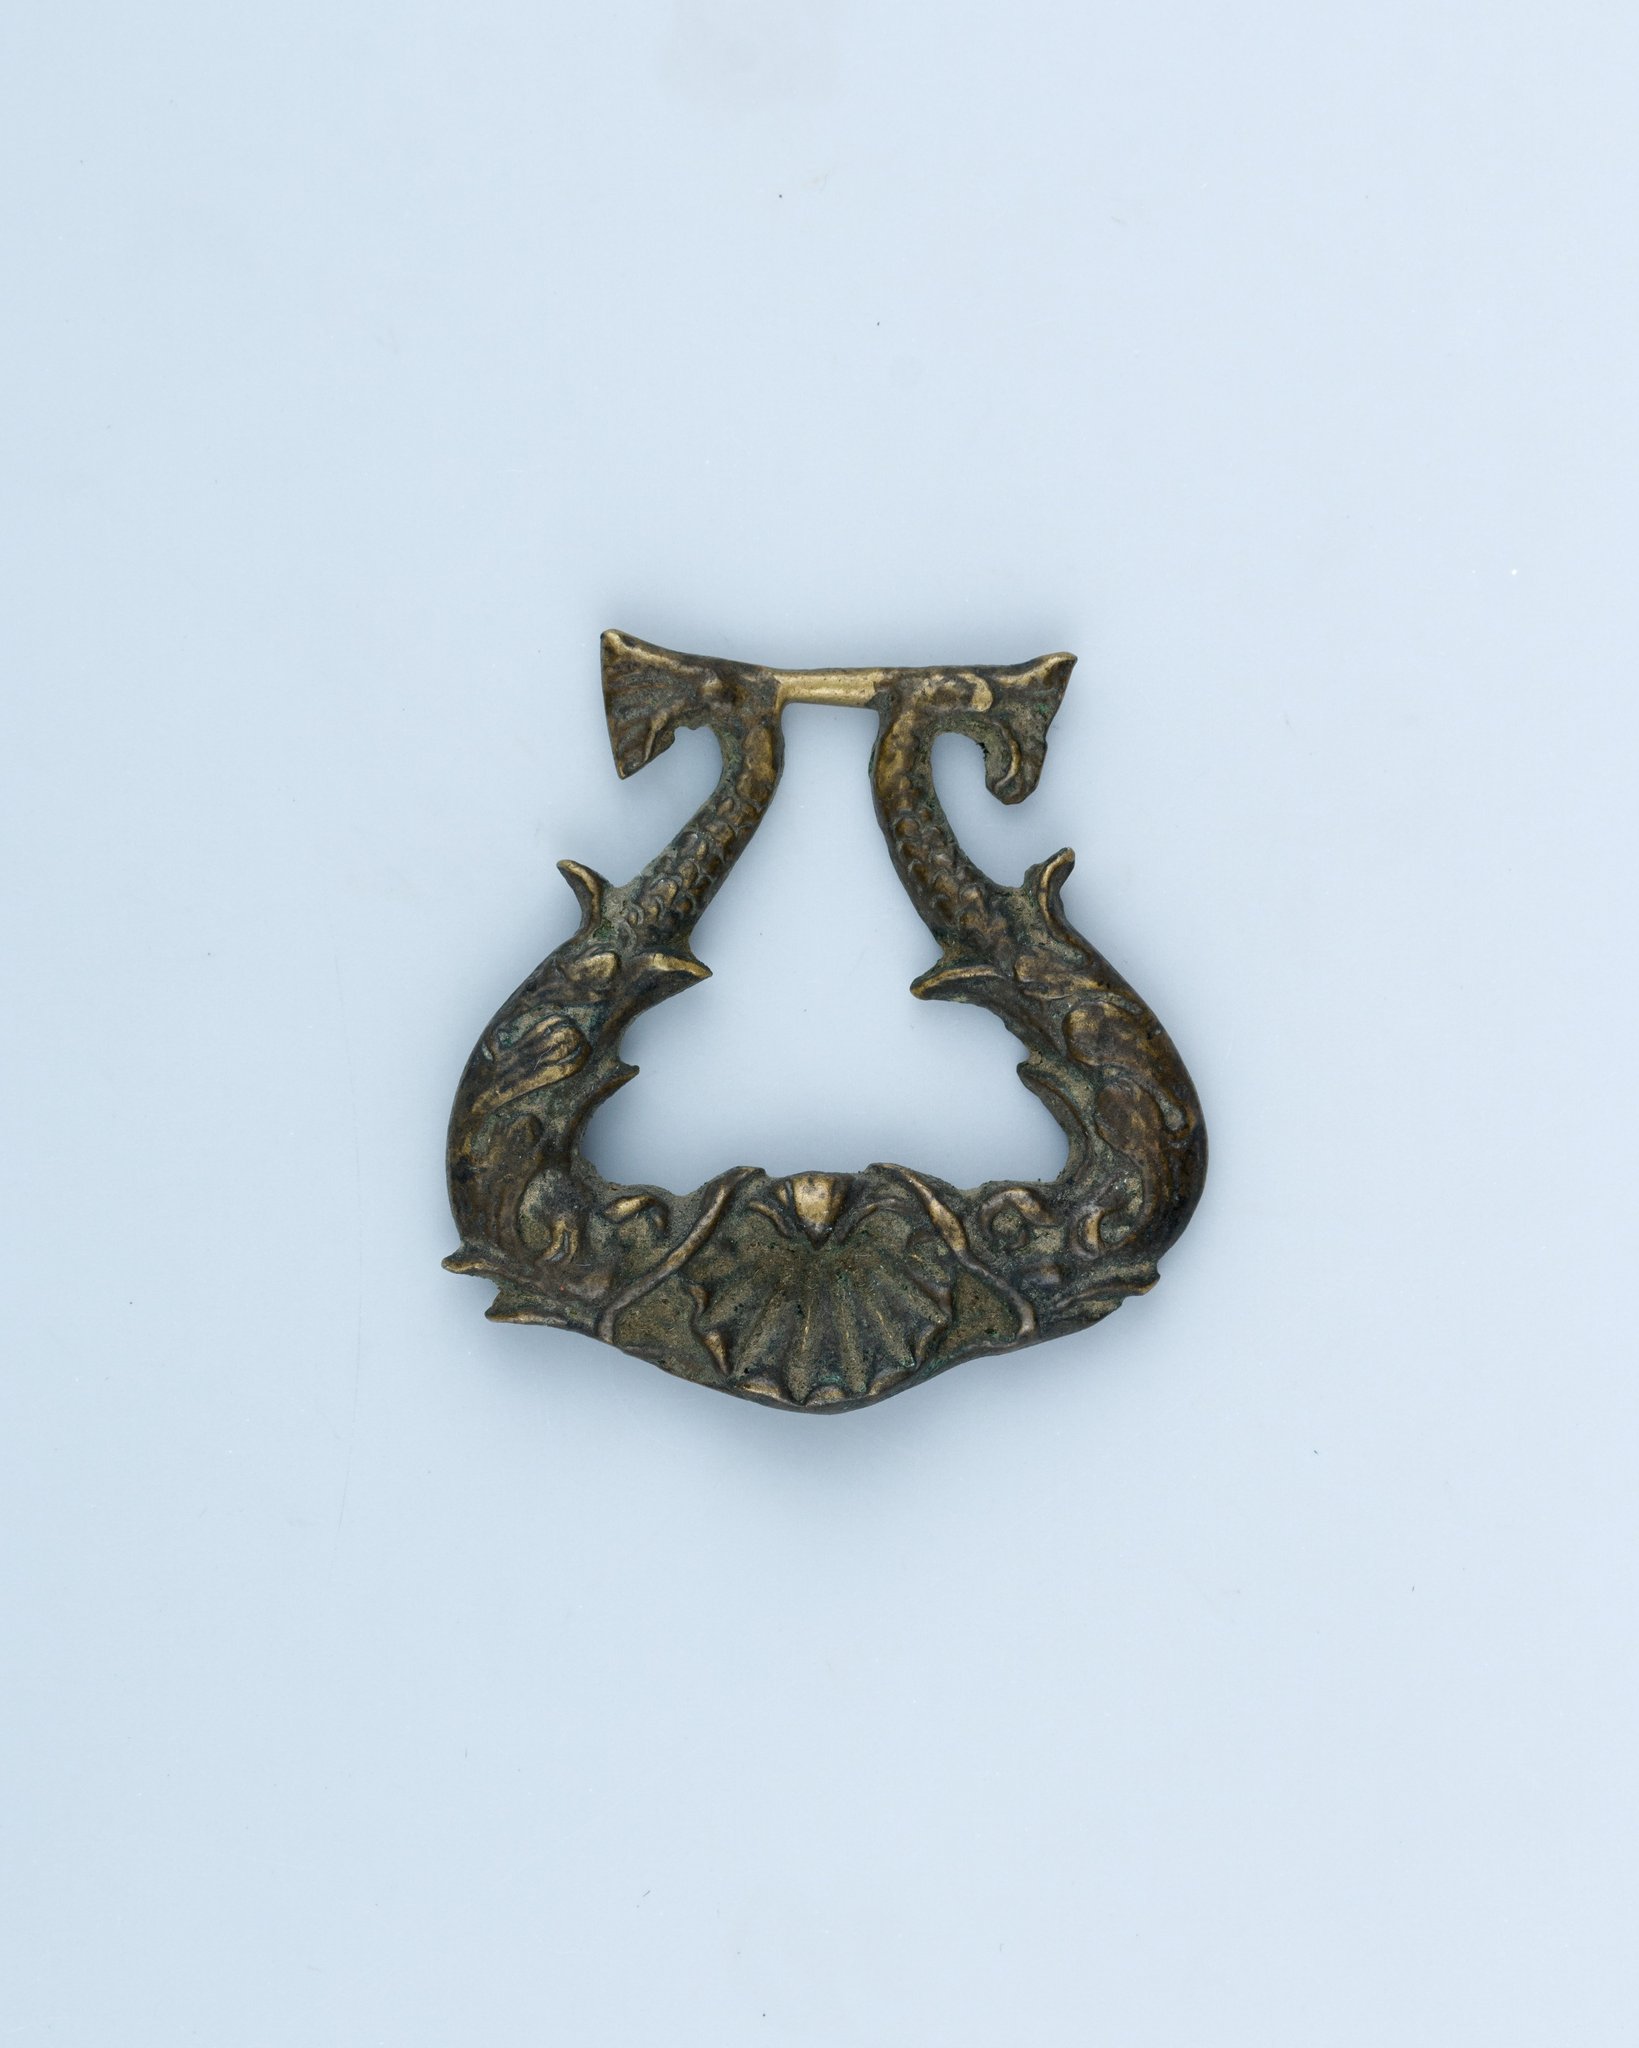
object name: pendant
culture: european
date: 1401-1700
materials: bronze